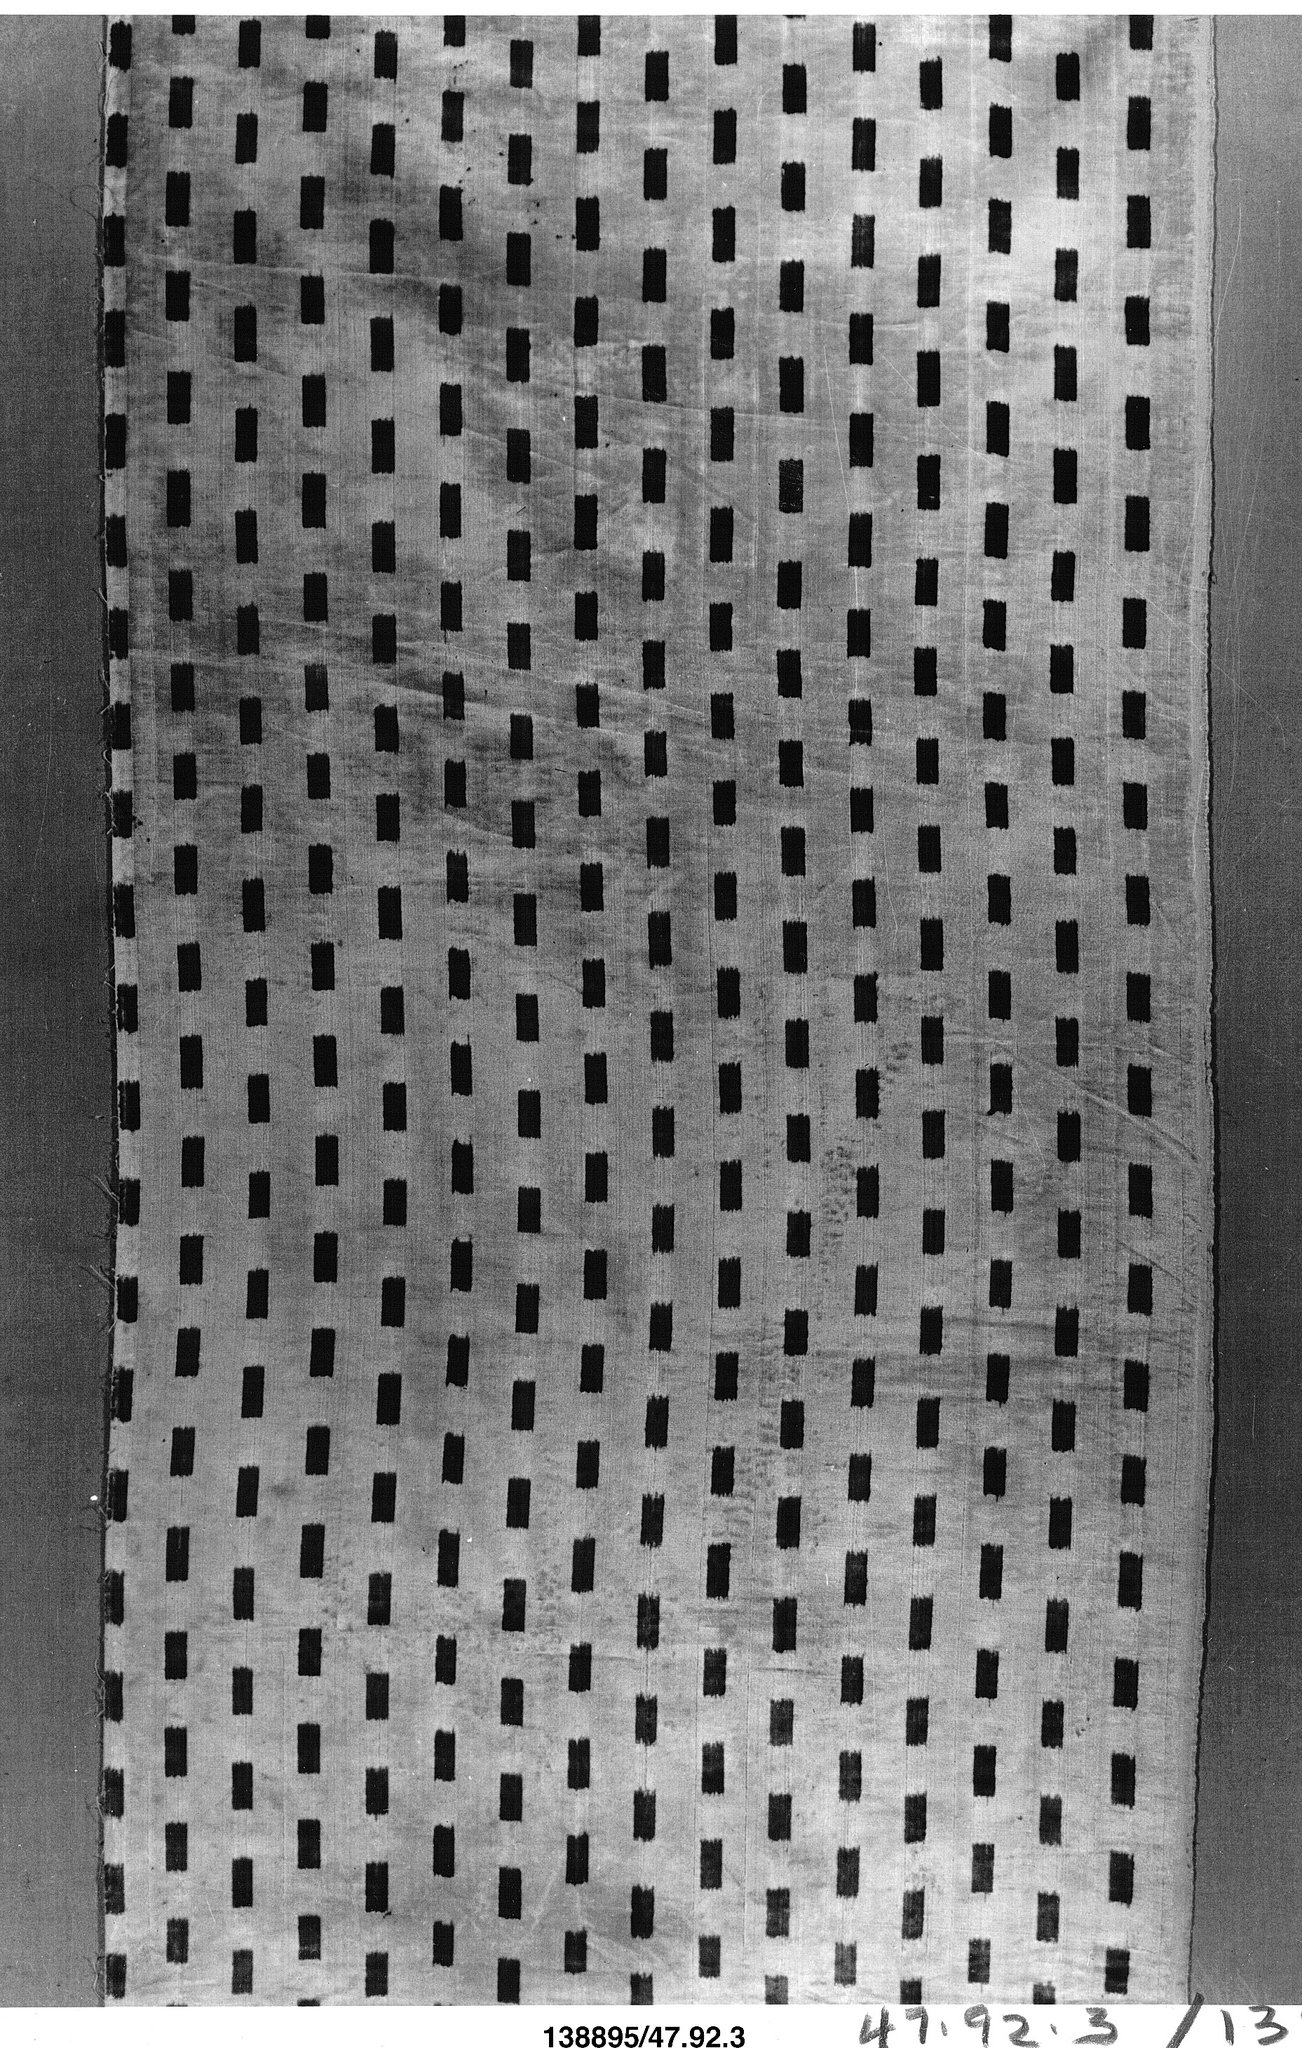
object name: piece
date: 1701-1800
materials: silk